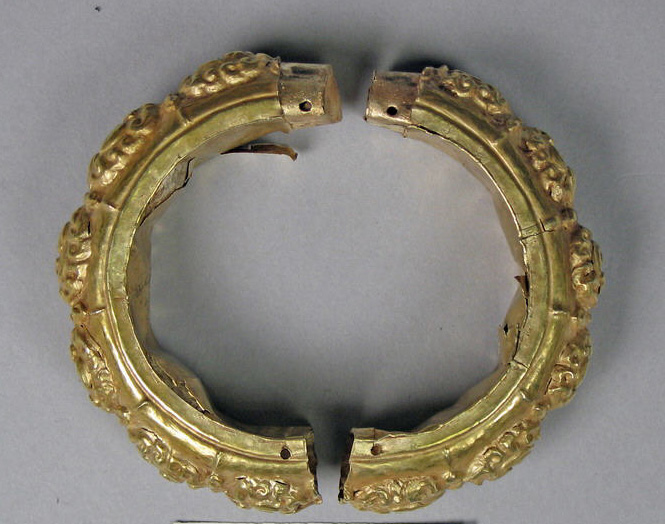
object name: bracelet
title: Bracelet, Repousse and Foliate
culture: indonesian, central java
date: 701-1200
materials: gold